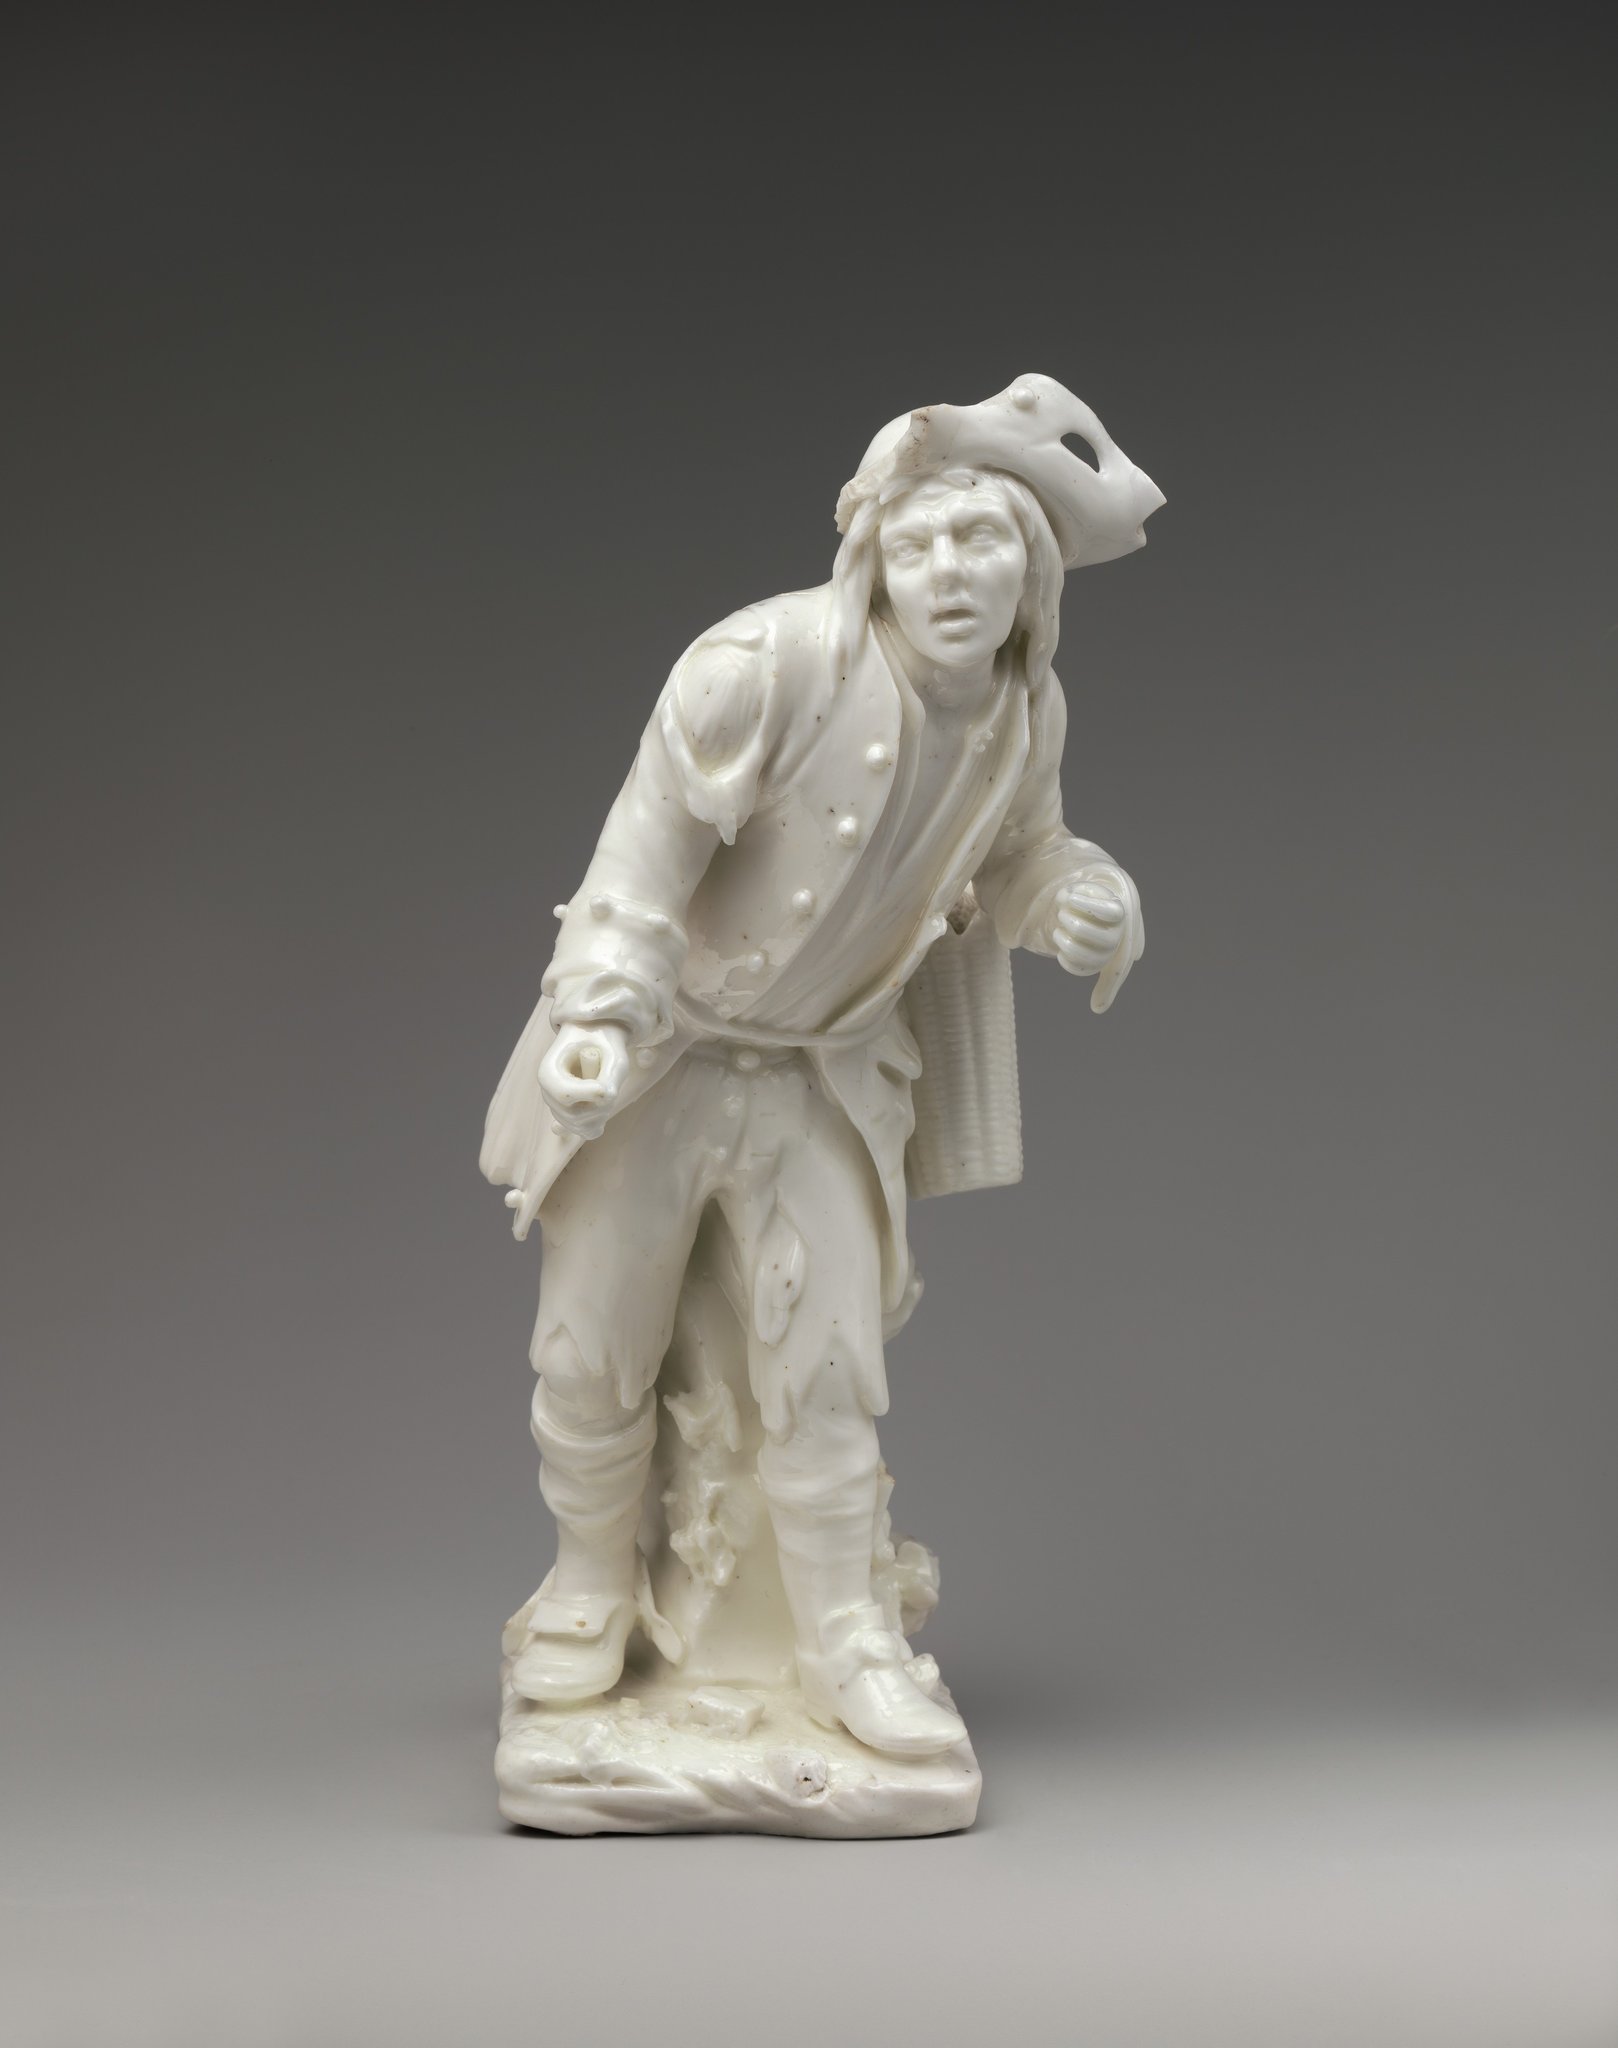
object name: figure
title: Street vendor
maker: mennecy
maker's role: manufactory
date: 1750-1760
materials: soft paste porcelain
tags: men